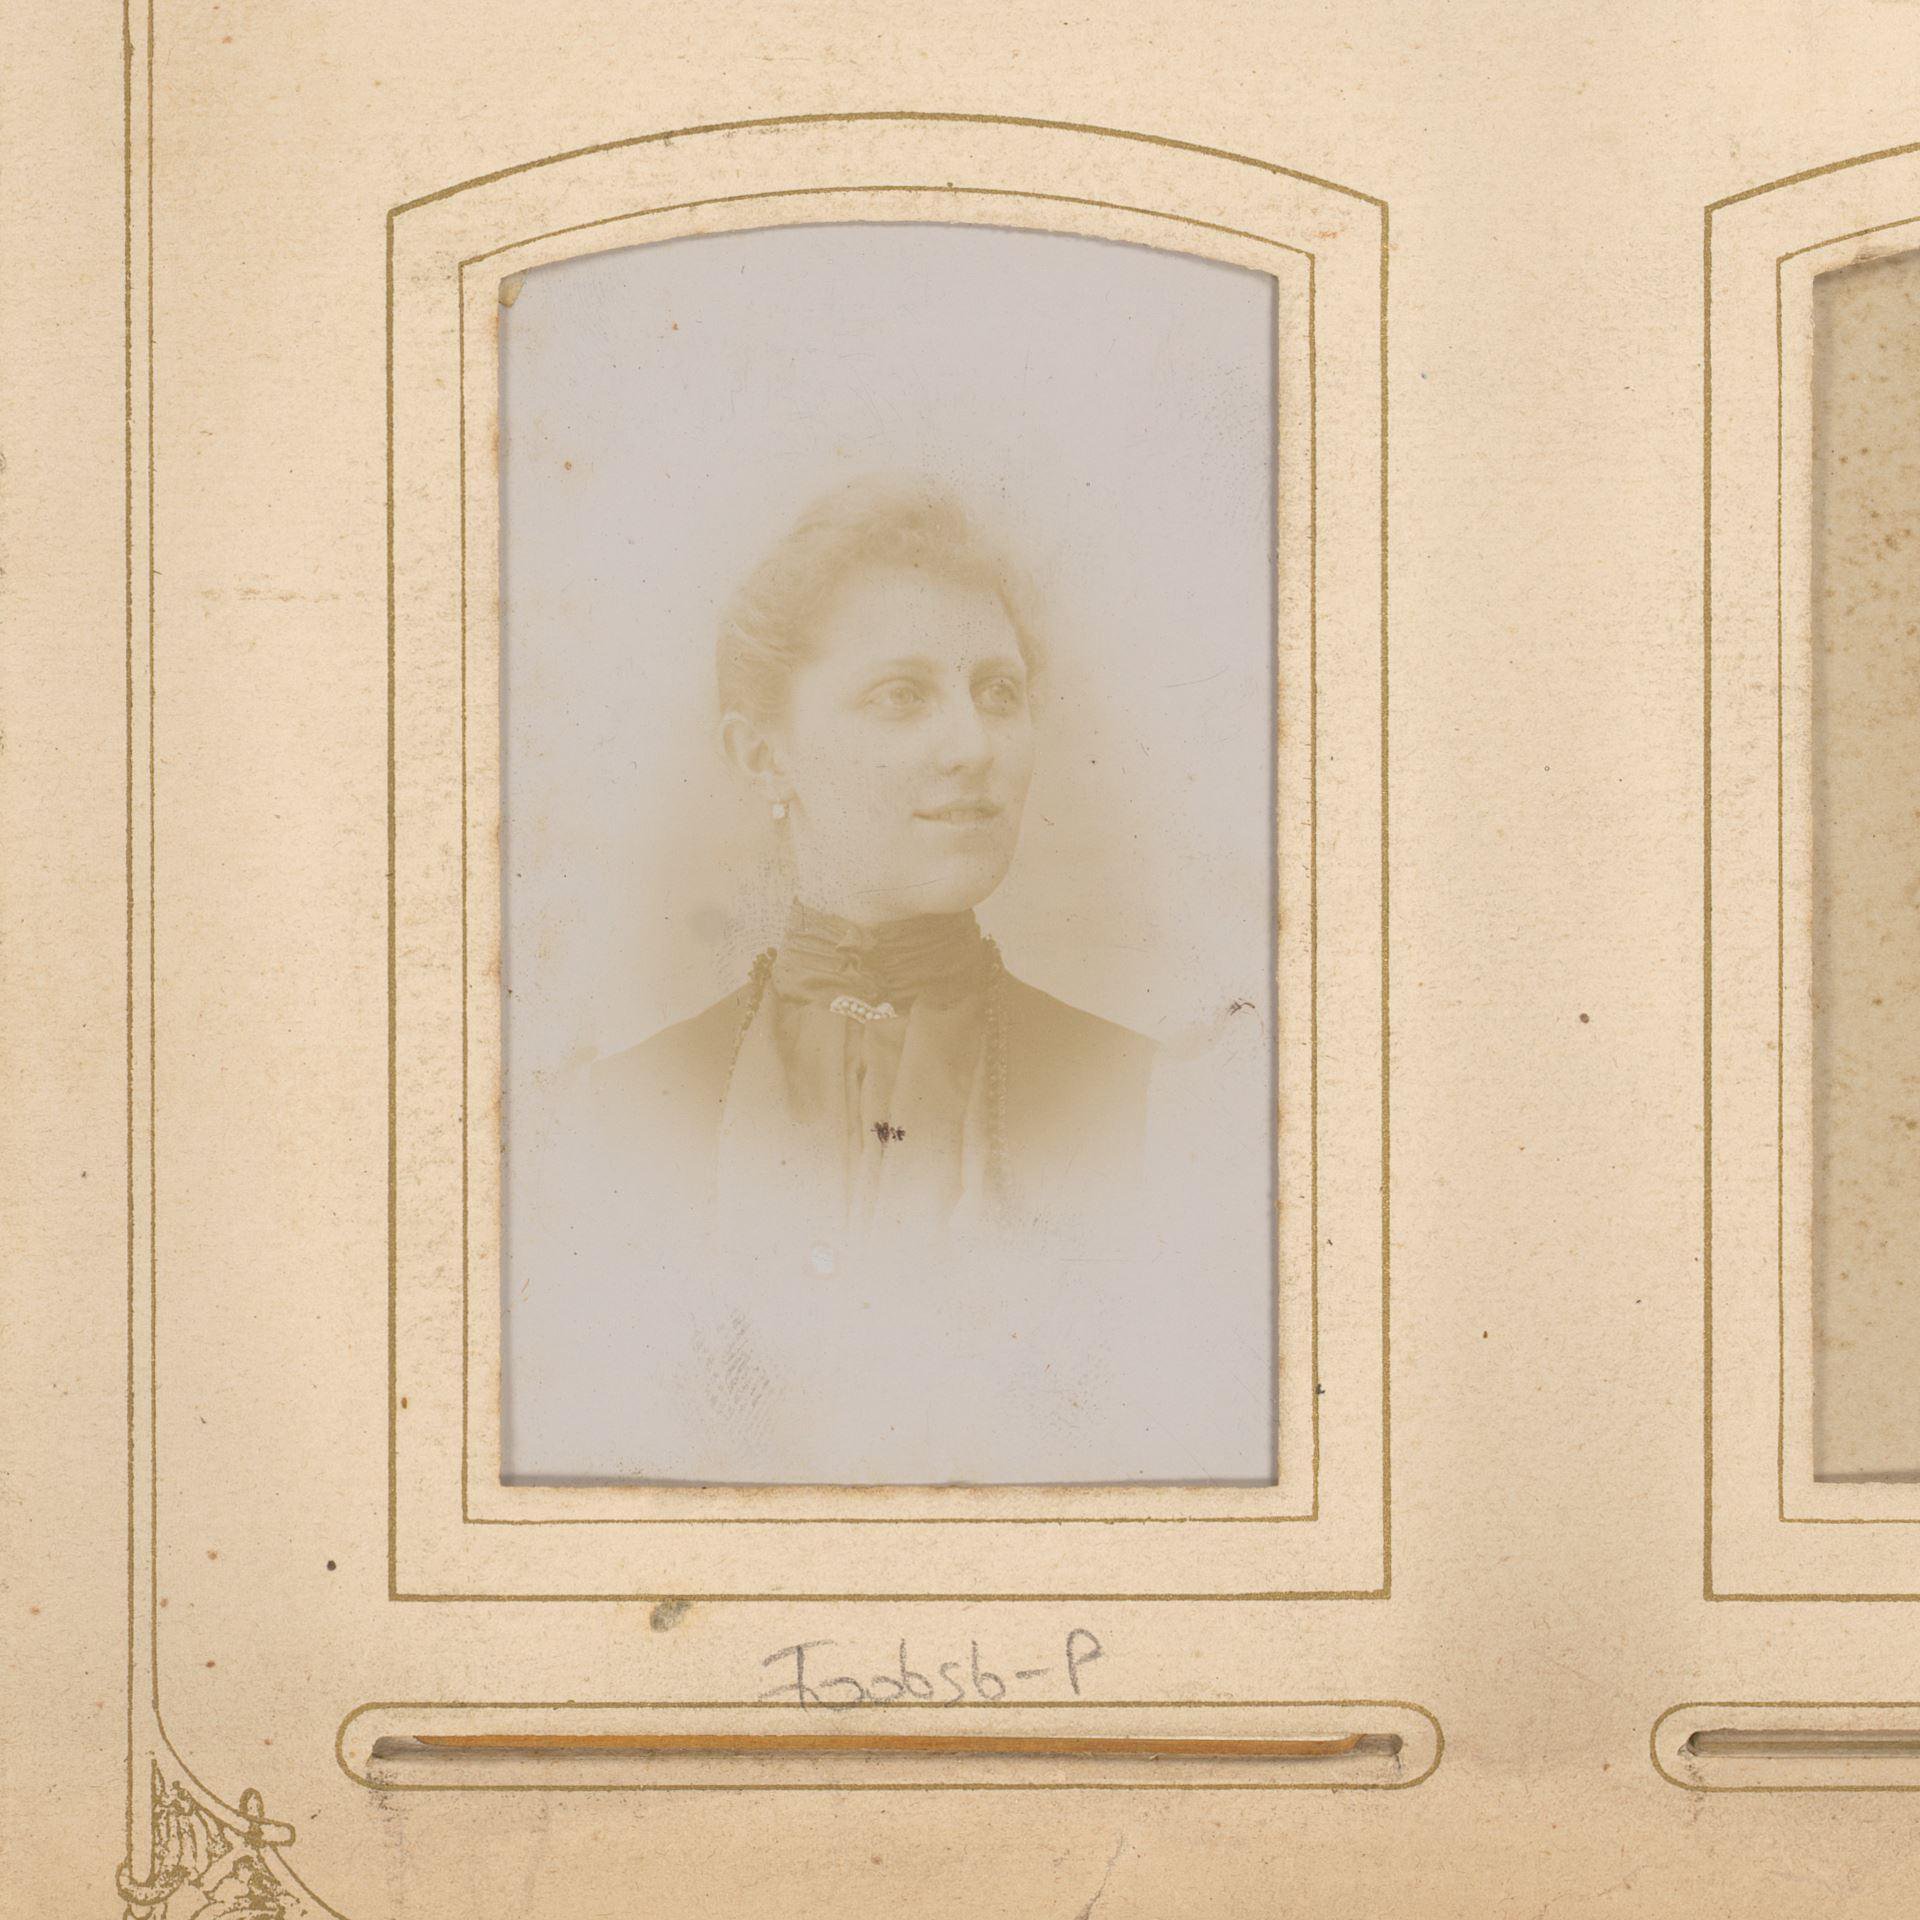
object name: photograph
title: Portret van een vrouw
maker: Anonymous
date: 1880-1940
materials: cardboard, photographic support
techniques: collodion silver print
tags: historical persons - bb - woman